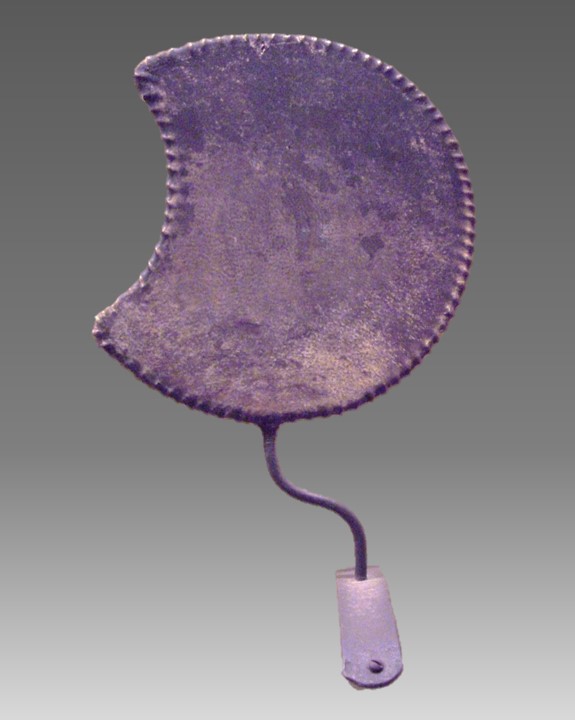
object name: candrapirai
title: Candra pirai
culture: indian, south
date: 1867-1900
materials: iron, skin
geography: india